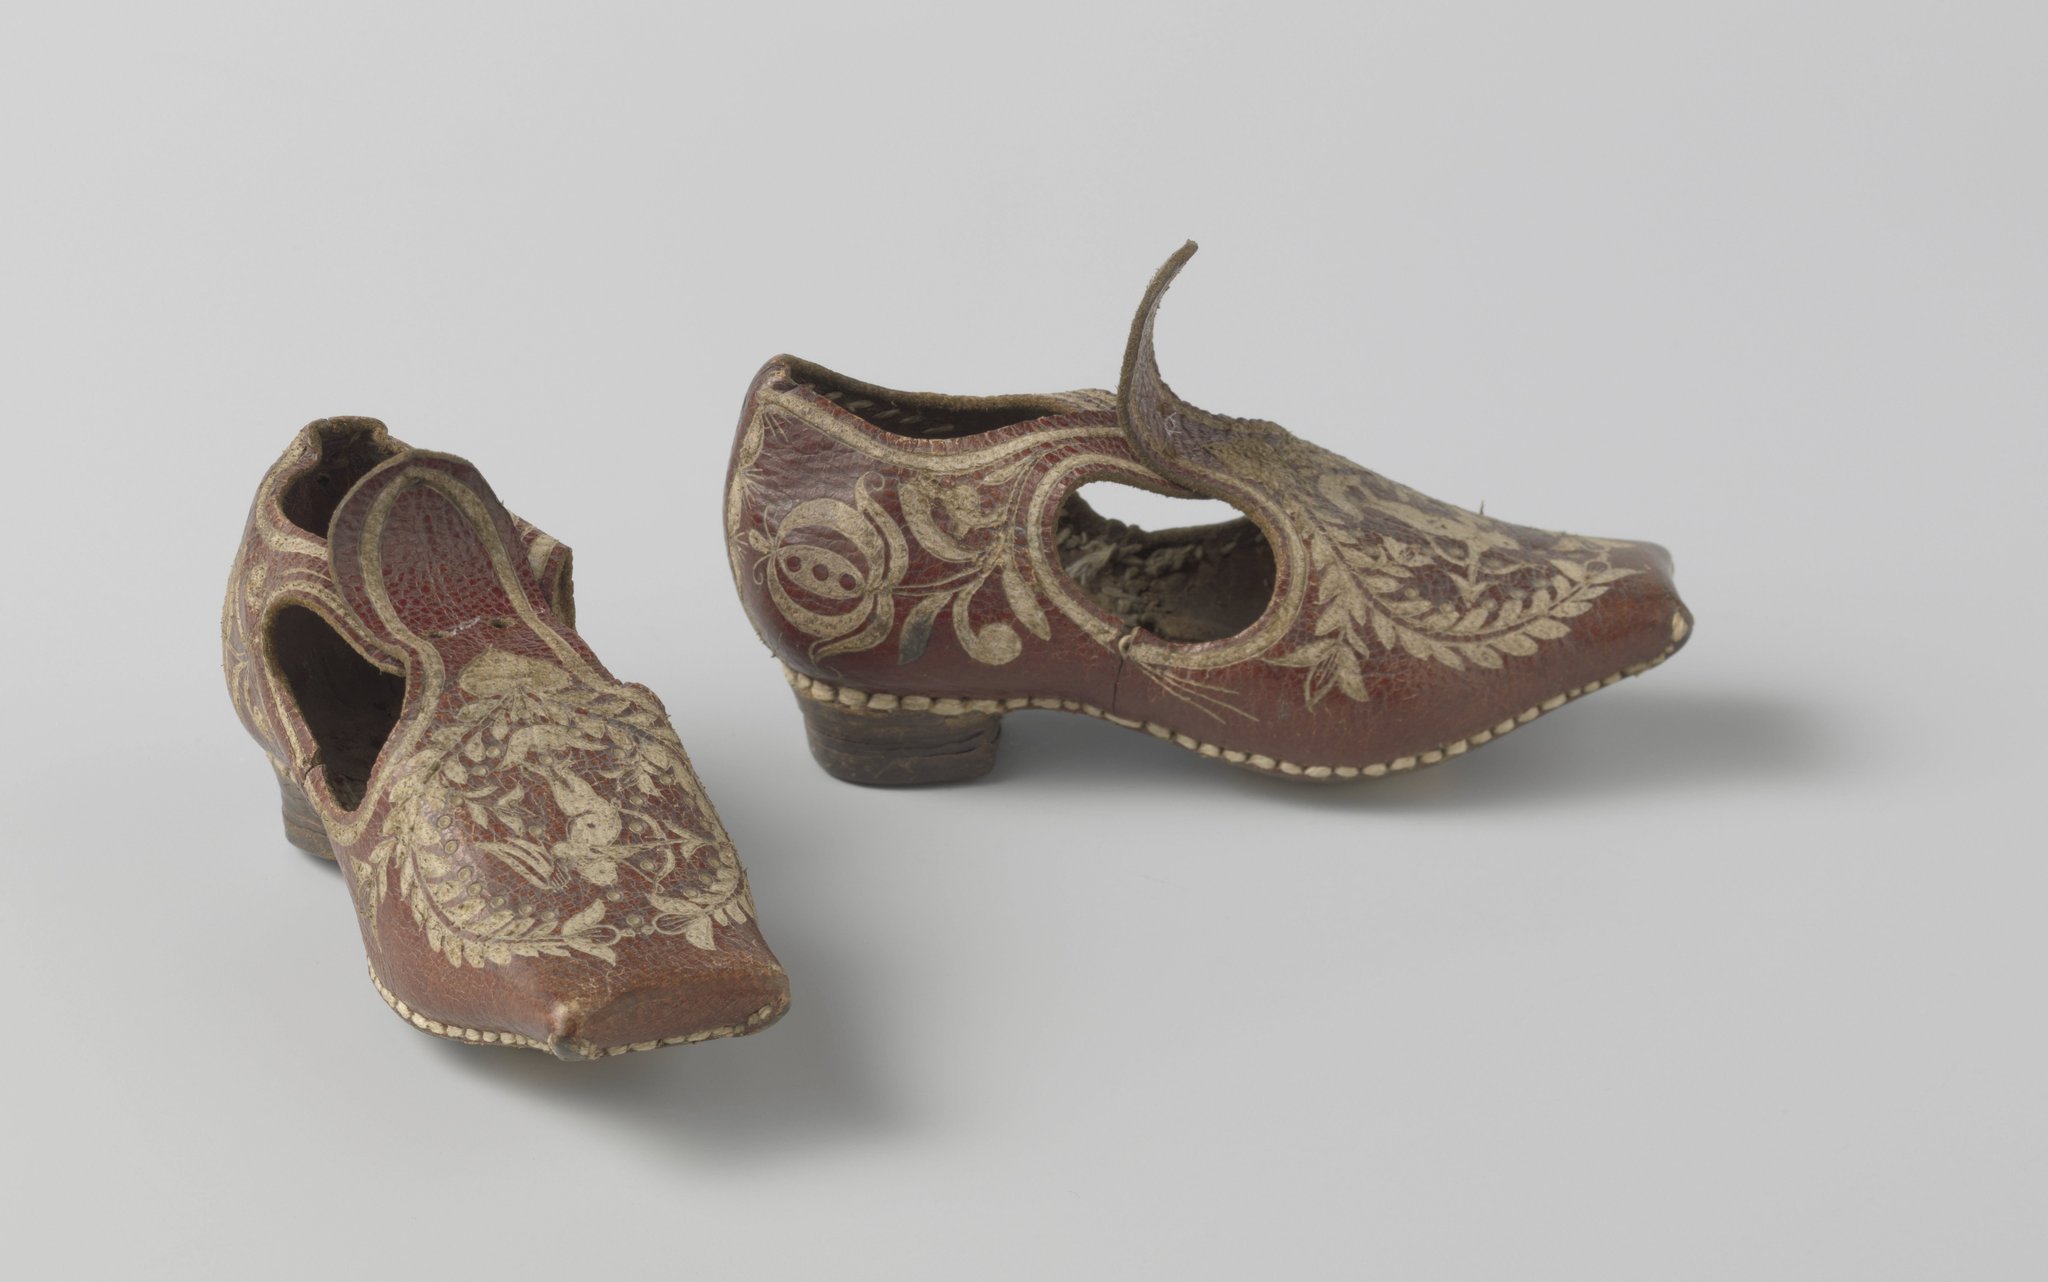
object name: shoe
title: Schoen van rood leer in miniatuurformaat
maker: Anonymous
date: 1640-1660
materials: leather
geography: northern netherlands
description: Een paar herenschoenen van roodleer (miniatuurformaat), links en rechts gelijk. lage, naar binnen gerichte hak, die niet plat op de grond staat. Platte, vierkante neus (lange bek). Hoog voorblad met tong, waarover twee riemen gesloten worden. zijopening tussen vóór- en achterblad. Witte beschildering van een cupido in een lauwerkrans en van granaatappels.